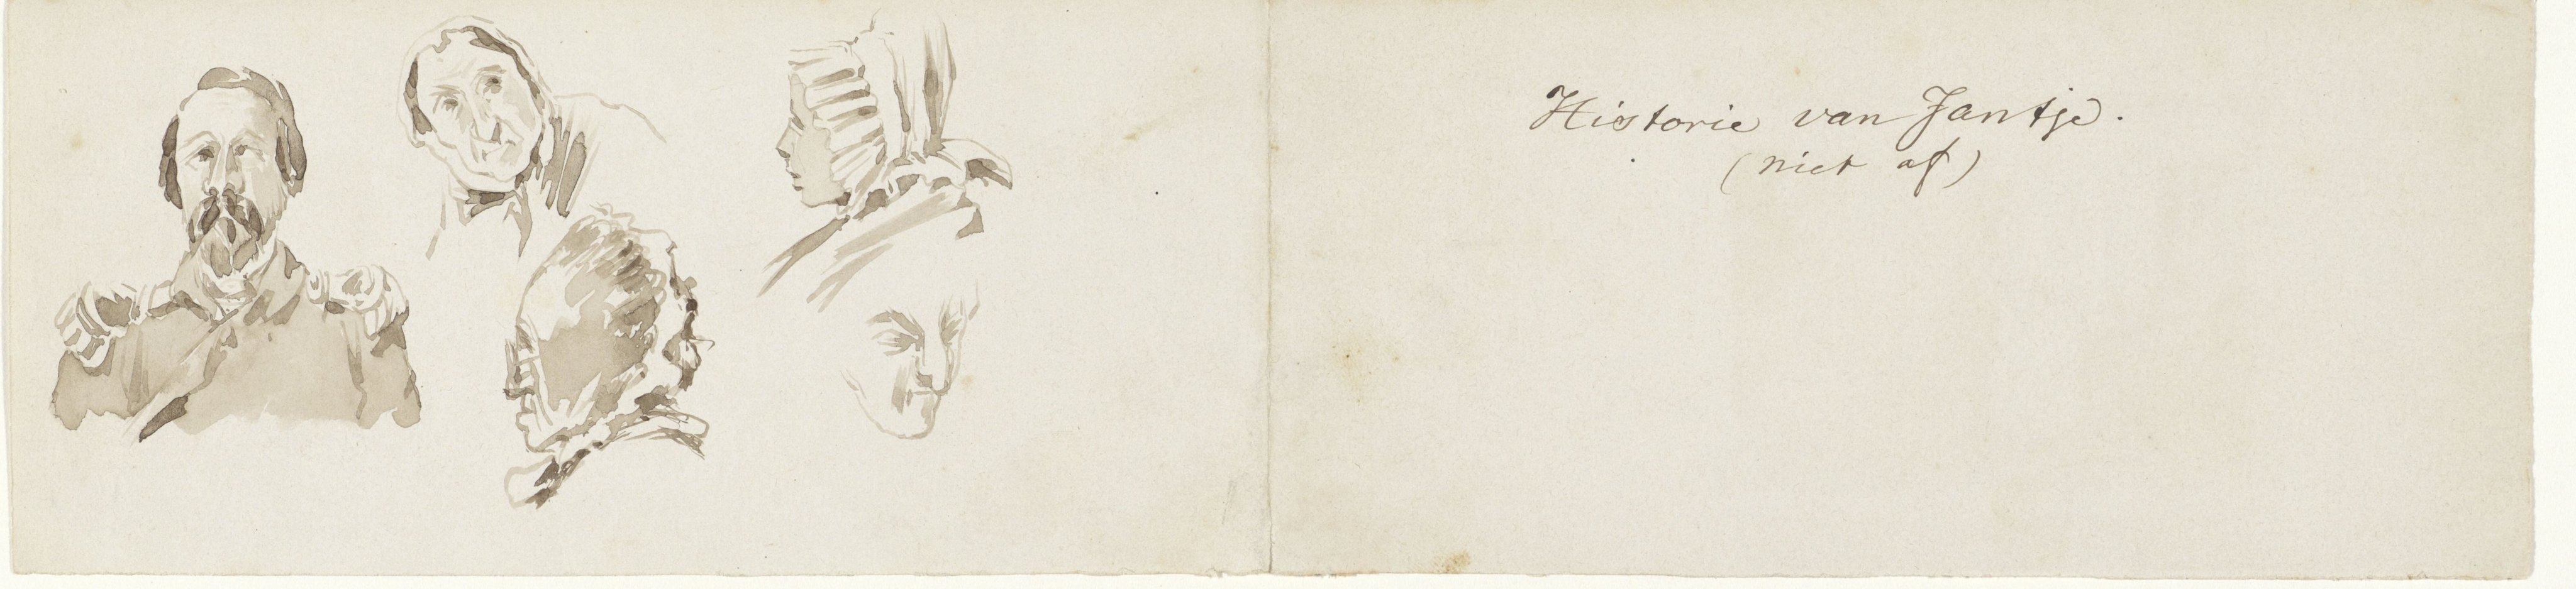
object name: drawing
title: Enkele schetsen voor de historie van Jantje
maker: pieter van loon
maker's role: draughtsman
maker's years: 1801-1873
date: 1811-1873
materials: paper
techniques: brush, pen